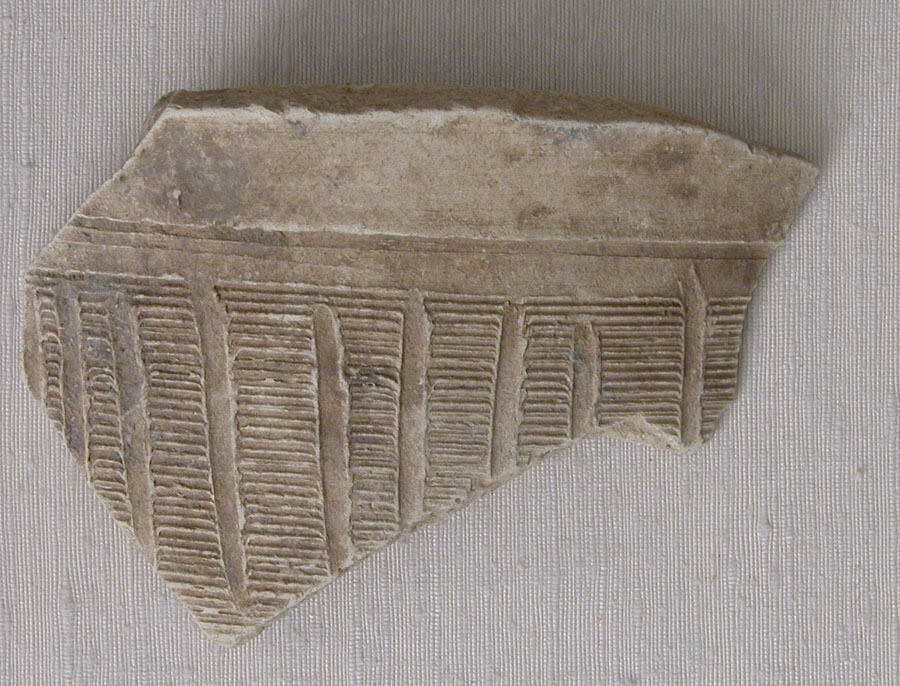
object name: fragment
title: Ceramic Fragment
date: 701-900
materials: earthenware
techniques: incising, molding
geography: iraq